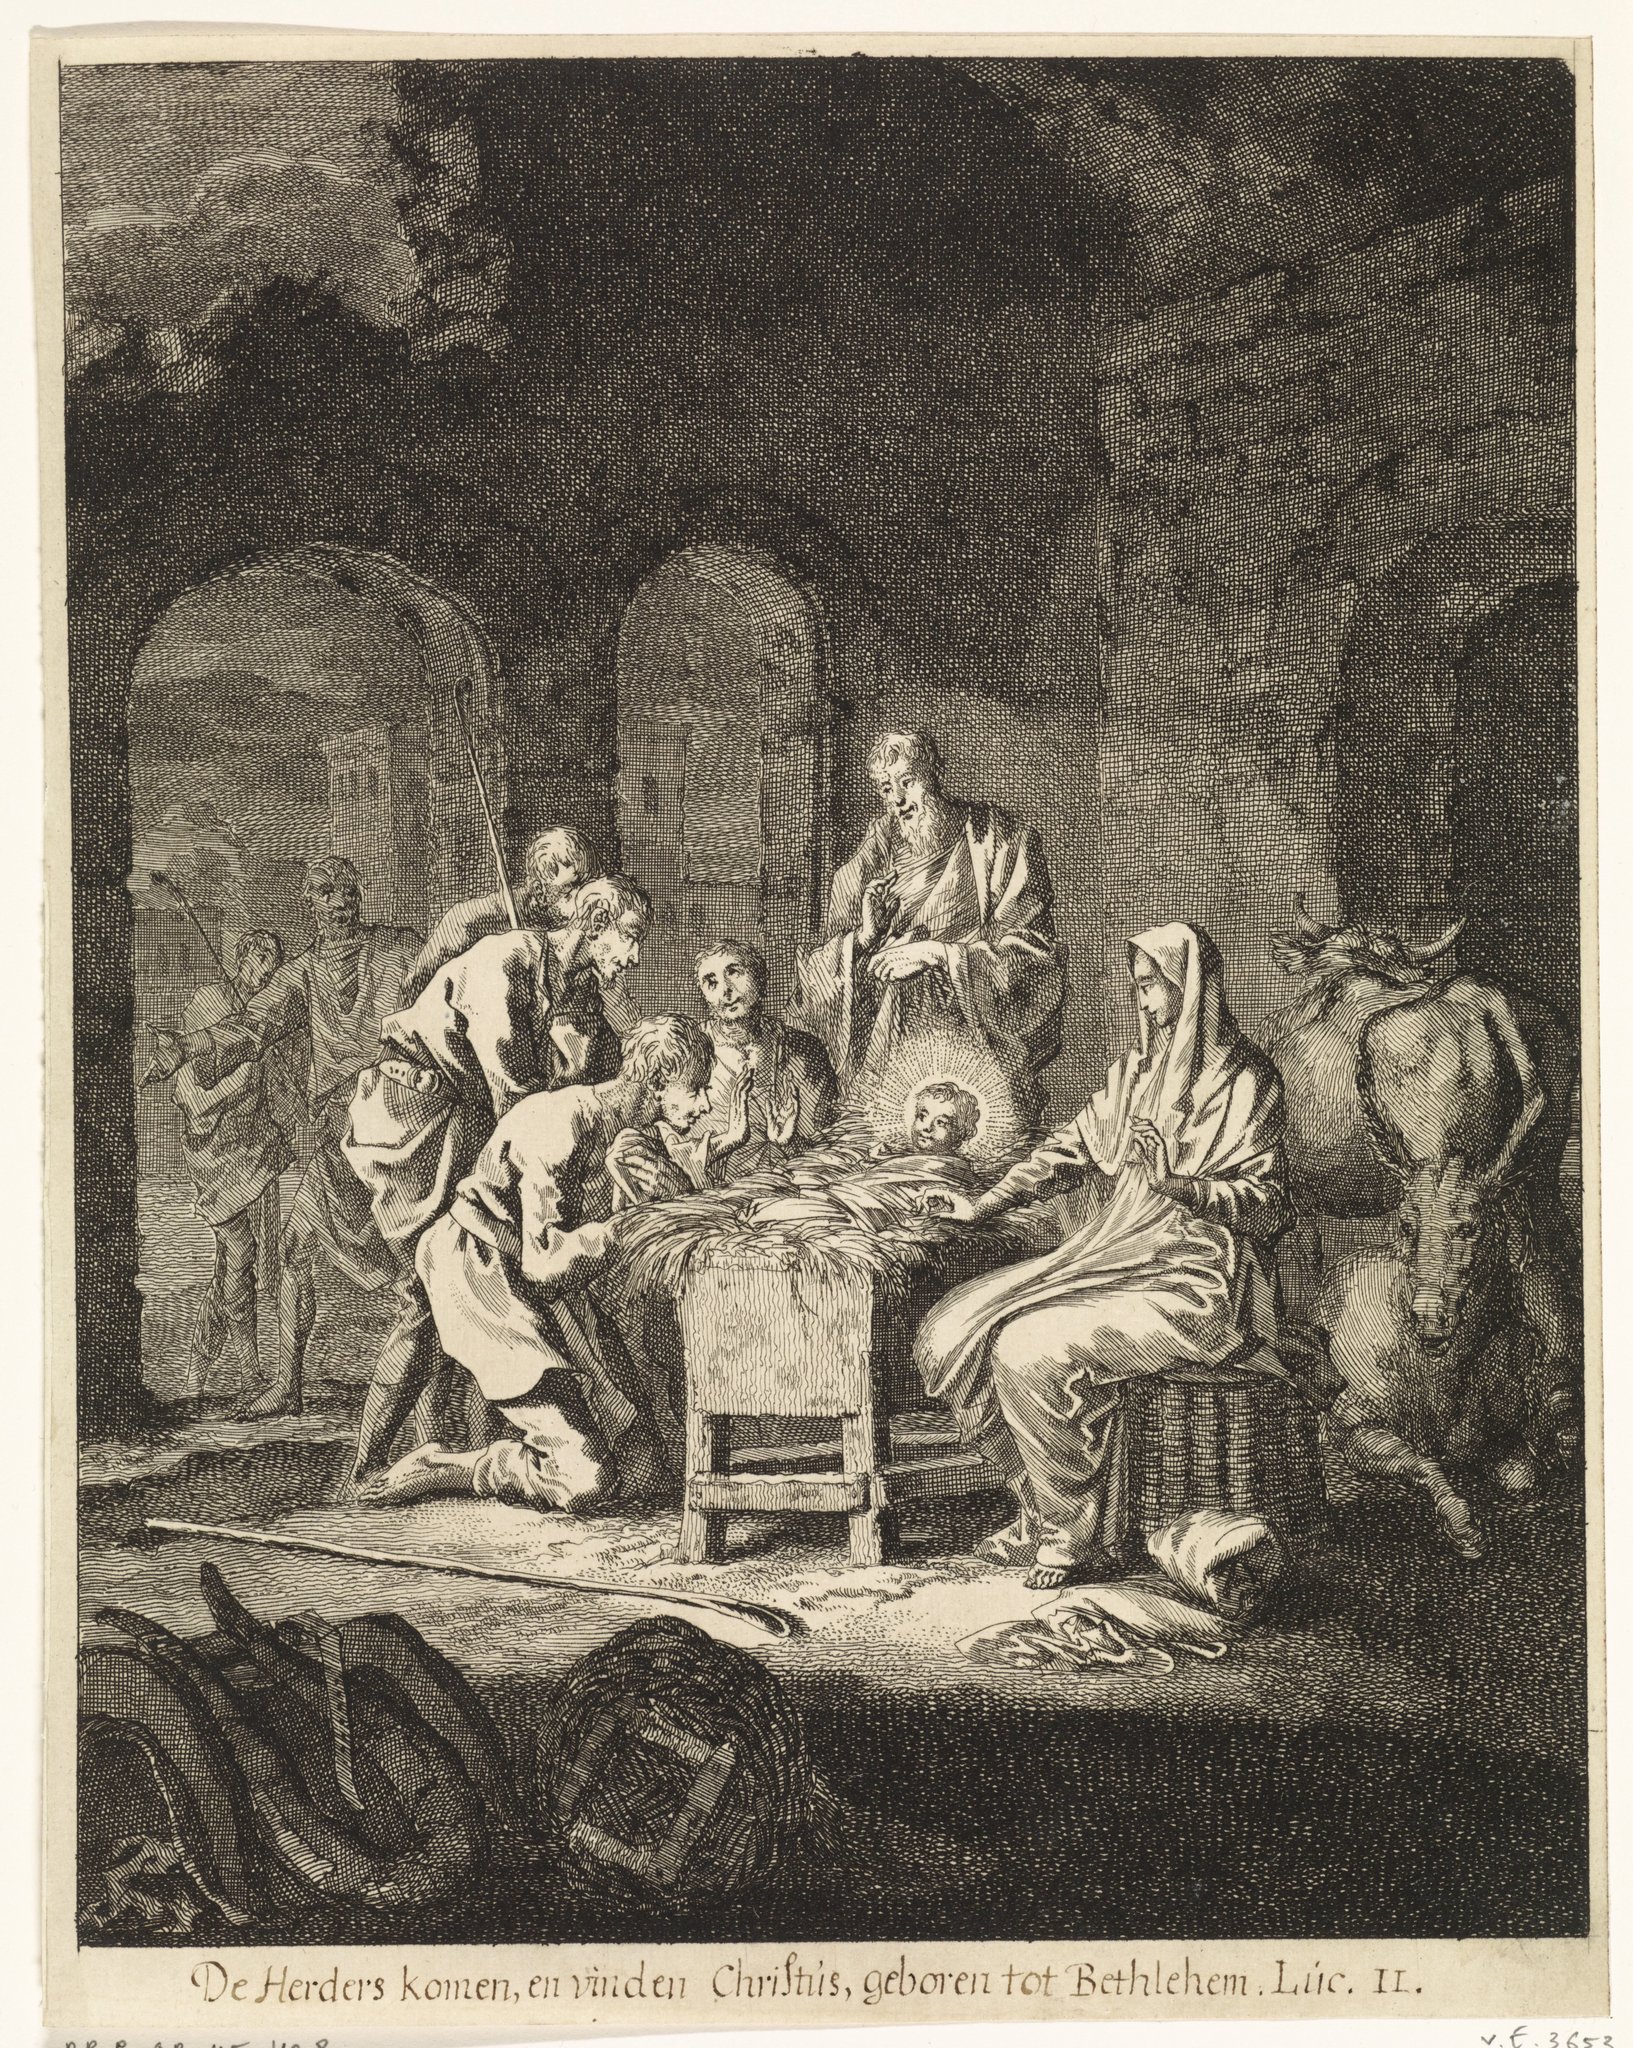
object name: print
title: Aanbidding der herders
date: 1708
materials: paper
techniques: etching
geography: amsterdam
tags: adoration of the christ-child by the shepherds; mary and joseph present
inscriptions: collector's mark: Lugt 2228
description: Proefdruk van een prent welke is opgenomen als illustratie in: Historiae Celebriores Veteris Testamenti. Christoph Weigel, 1708.